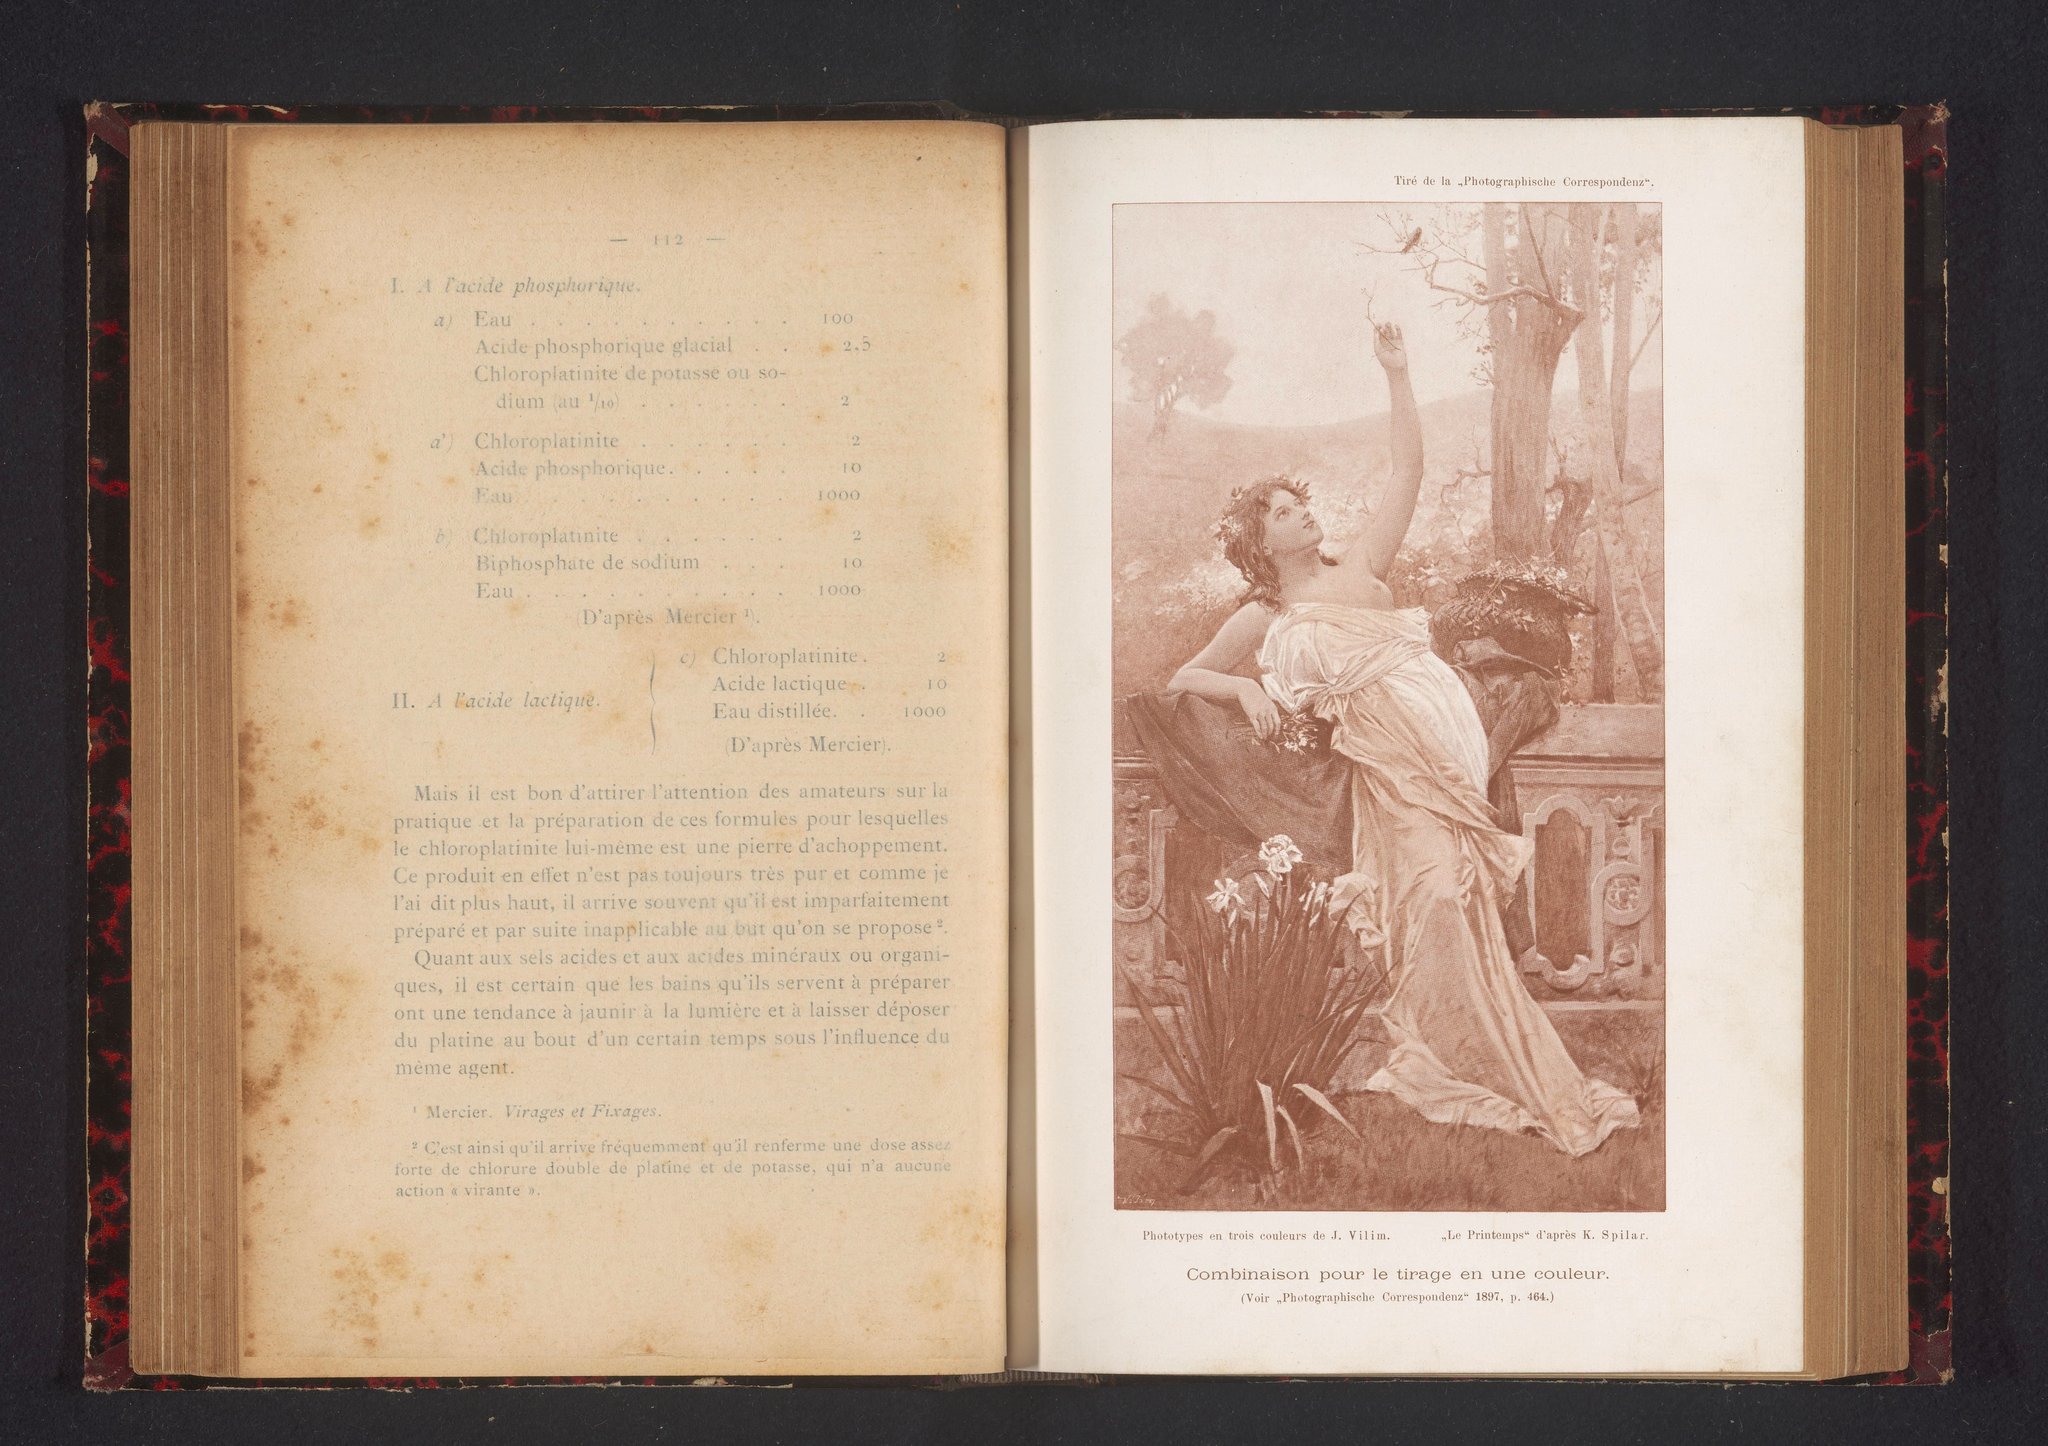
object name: photomechanical print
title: Reproductie van Le Printemps door K. Spilar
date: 1893-1898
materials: paper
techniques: autotype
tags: adult woman, spring landscape; landscape symbolizing spring (the four seasons of the year)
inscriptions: inscription: ‘(Voir "Photographische Correspondez"1897, p. 464.)’